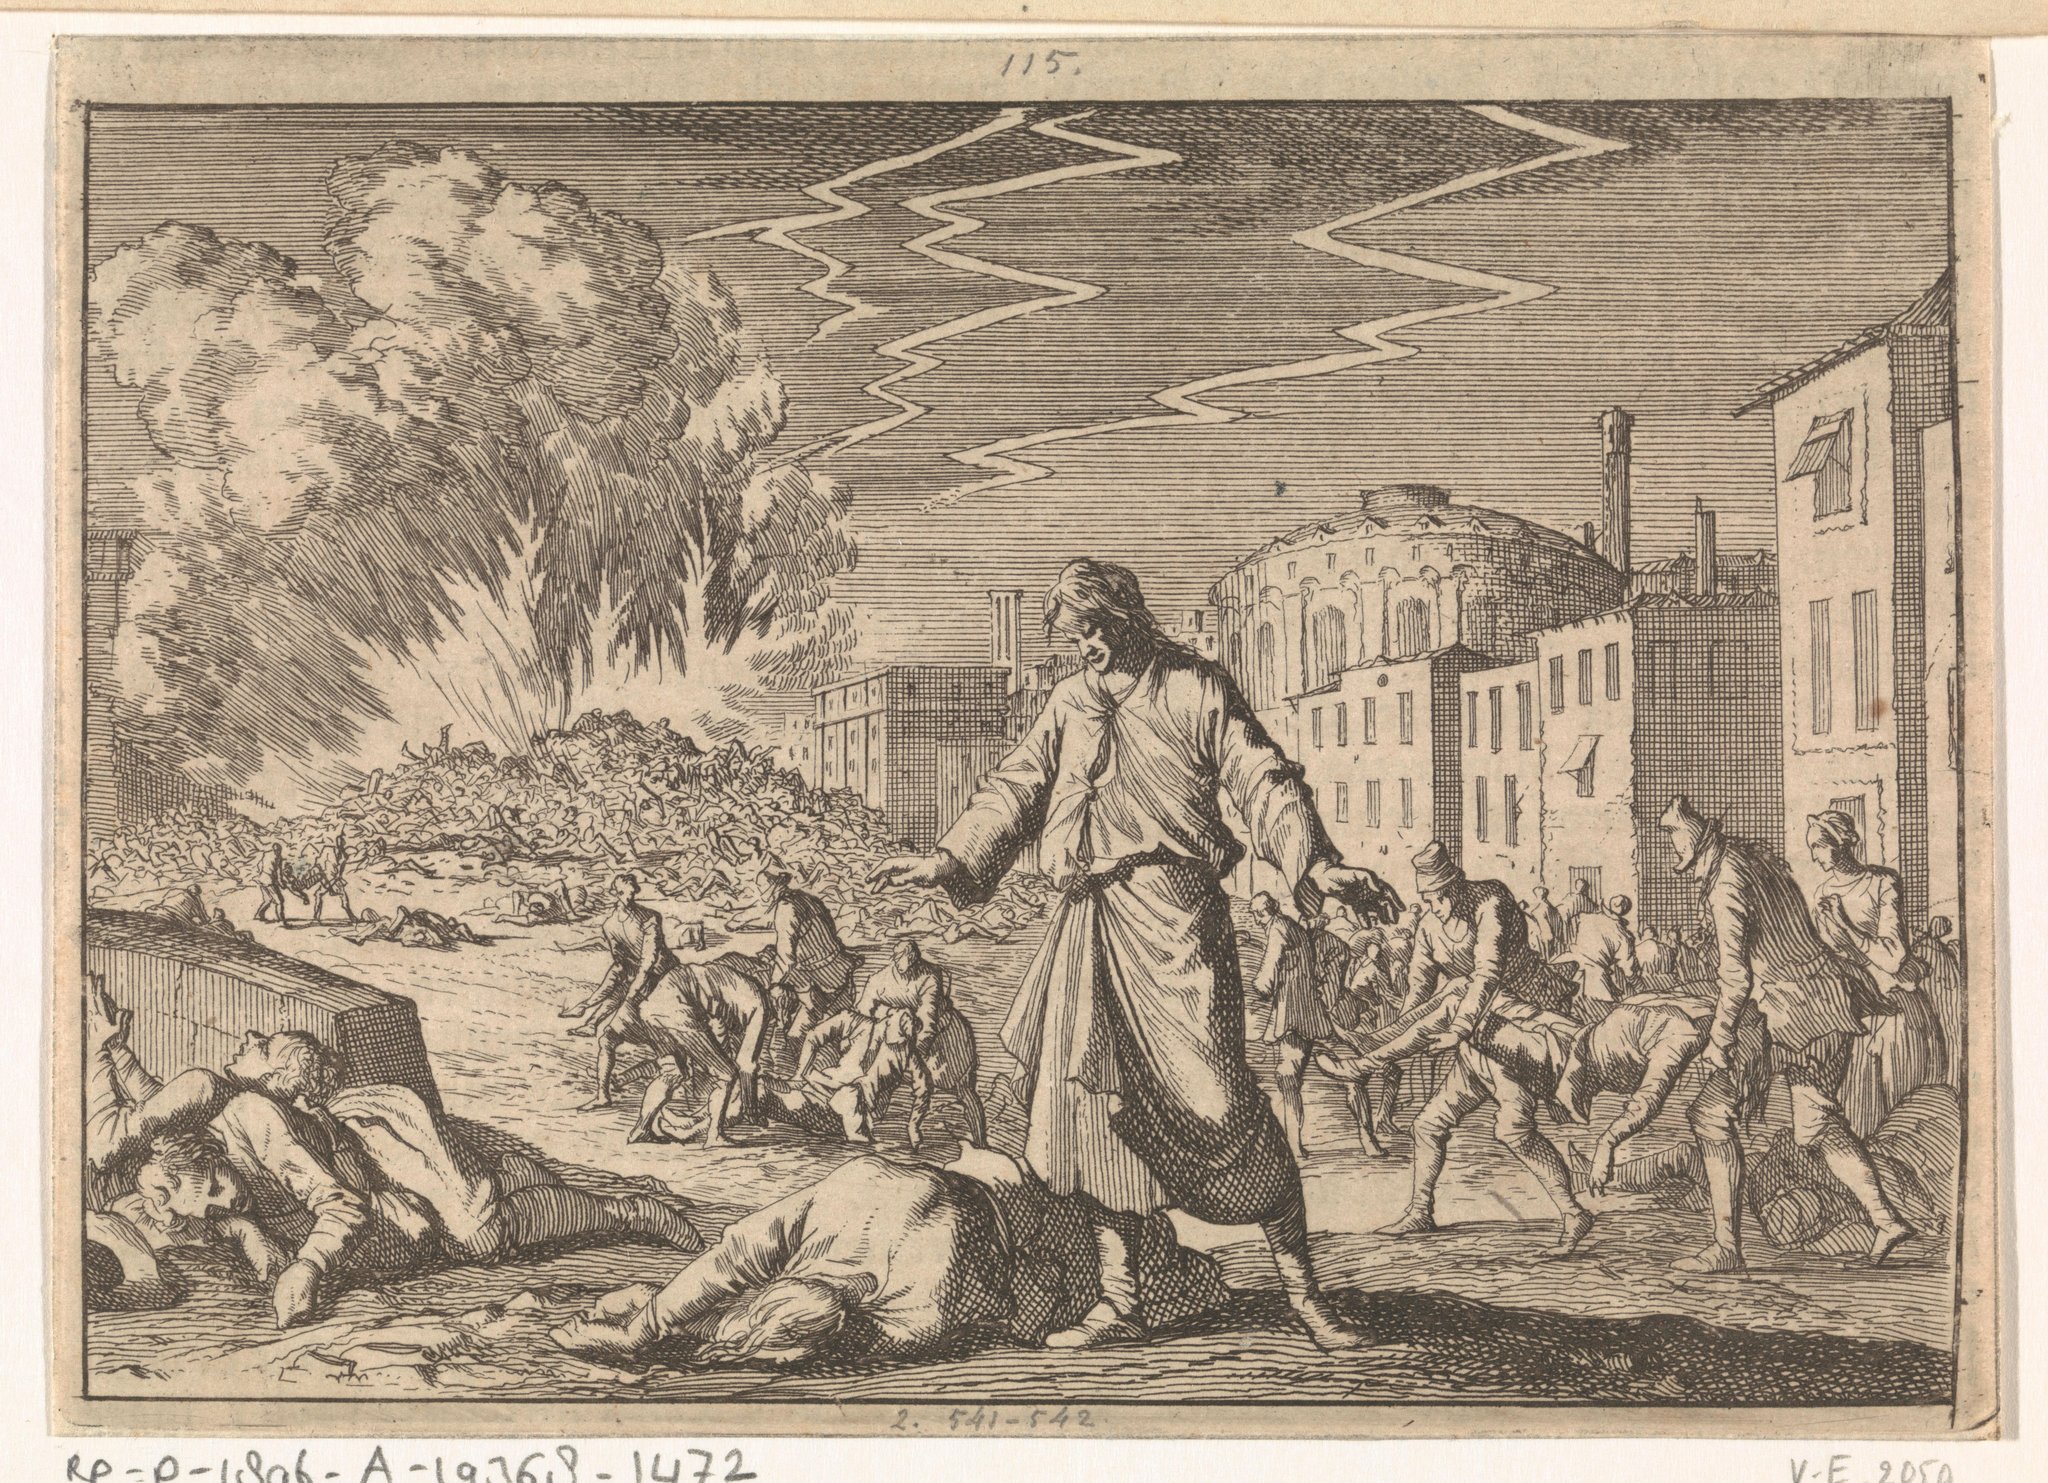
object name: book illustration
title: Pest te Napels, 1656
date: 1698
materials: paper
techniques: etching, letterpress printing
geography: leiden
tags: plague, naples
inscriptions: collector's mark: Lugt 2228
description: Illustratie uit: Gottfried, Johann Ludwig. Historische kronyck; vervattende een (...) beschrijvingh der aldergedenckwaerdigste geschiedenissen des weerelds, van den aenvangh der scheppingh tot (...) 1576 (2 delen). Leiden: Pieter van der Aa, 1698, dl. II, p. 541.